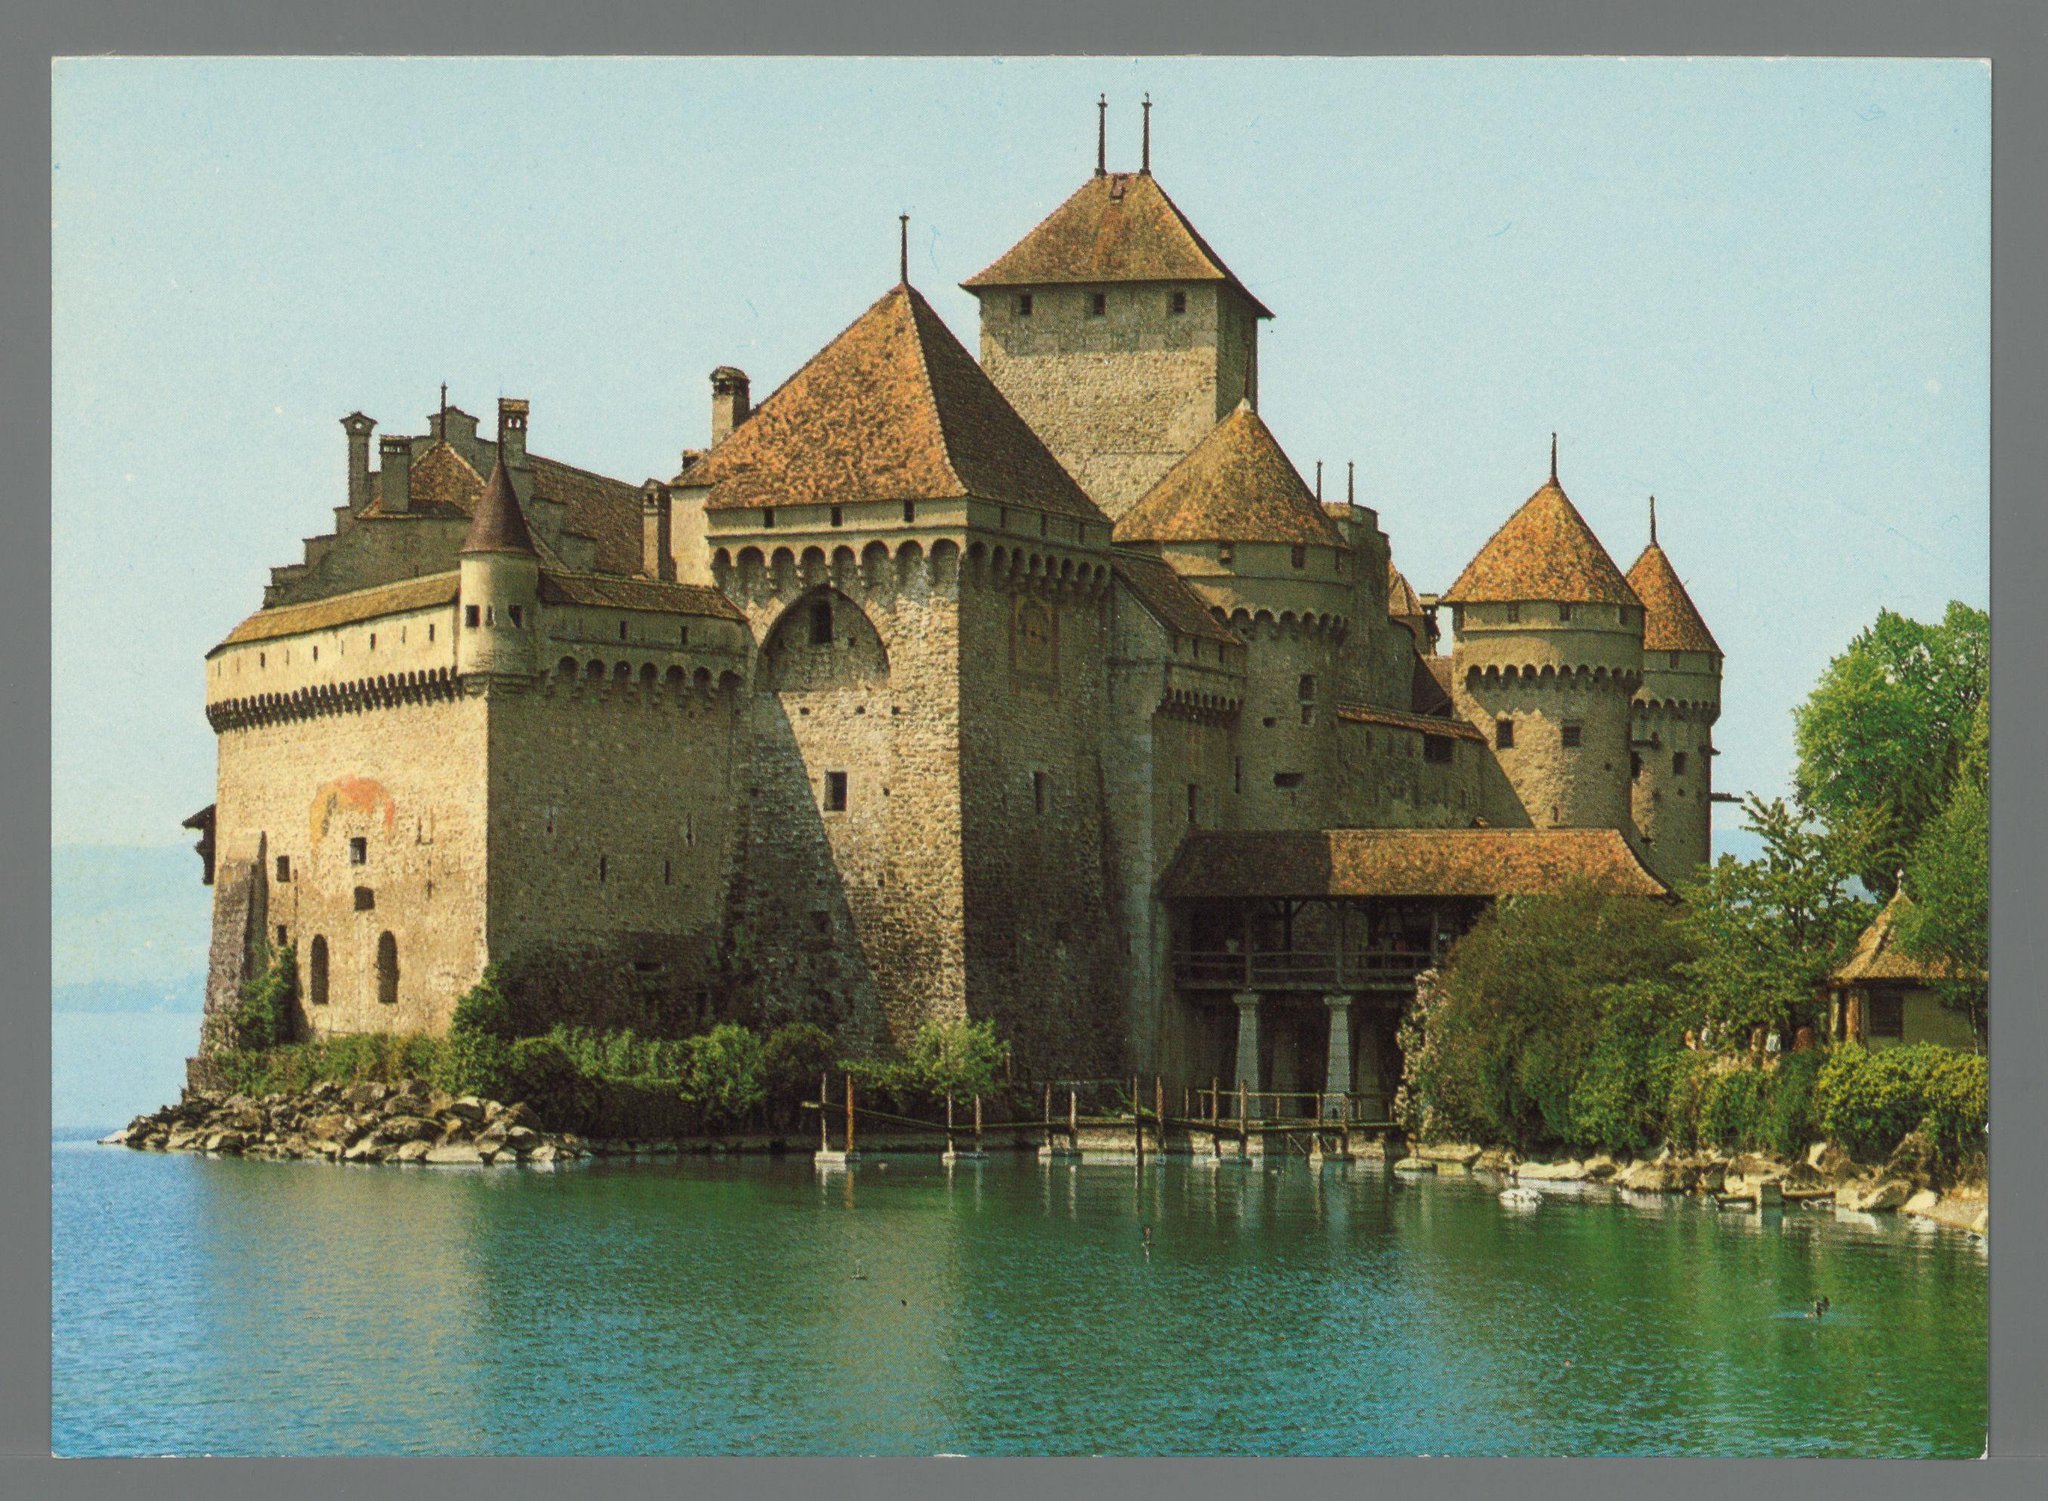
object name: photomechanical print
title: Lac Leman. Château de Chillon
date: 1970-1990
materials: cardboard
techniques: offset printed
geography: montreux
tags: castle, lake